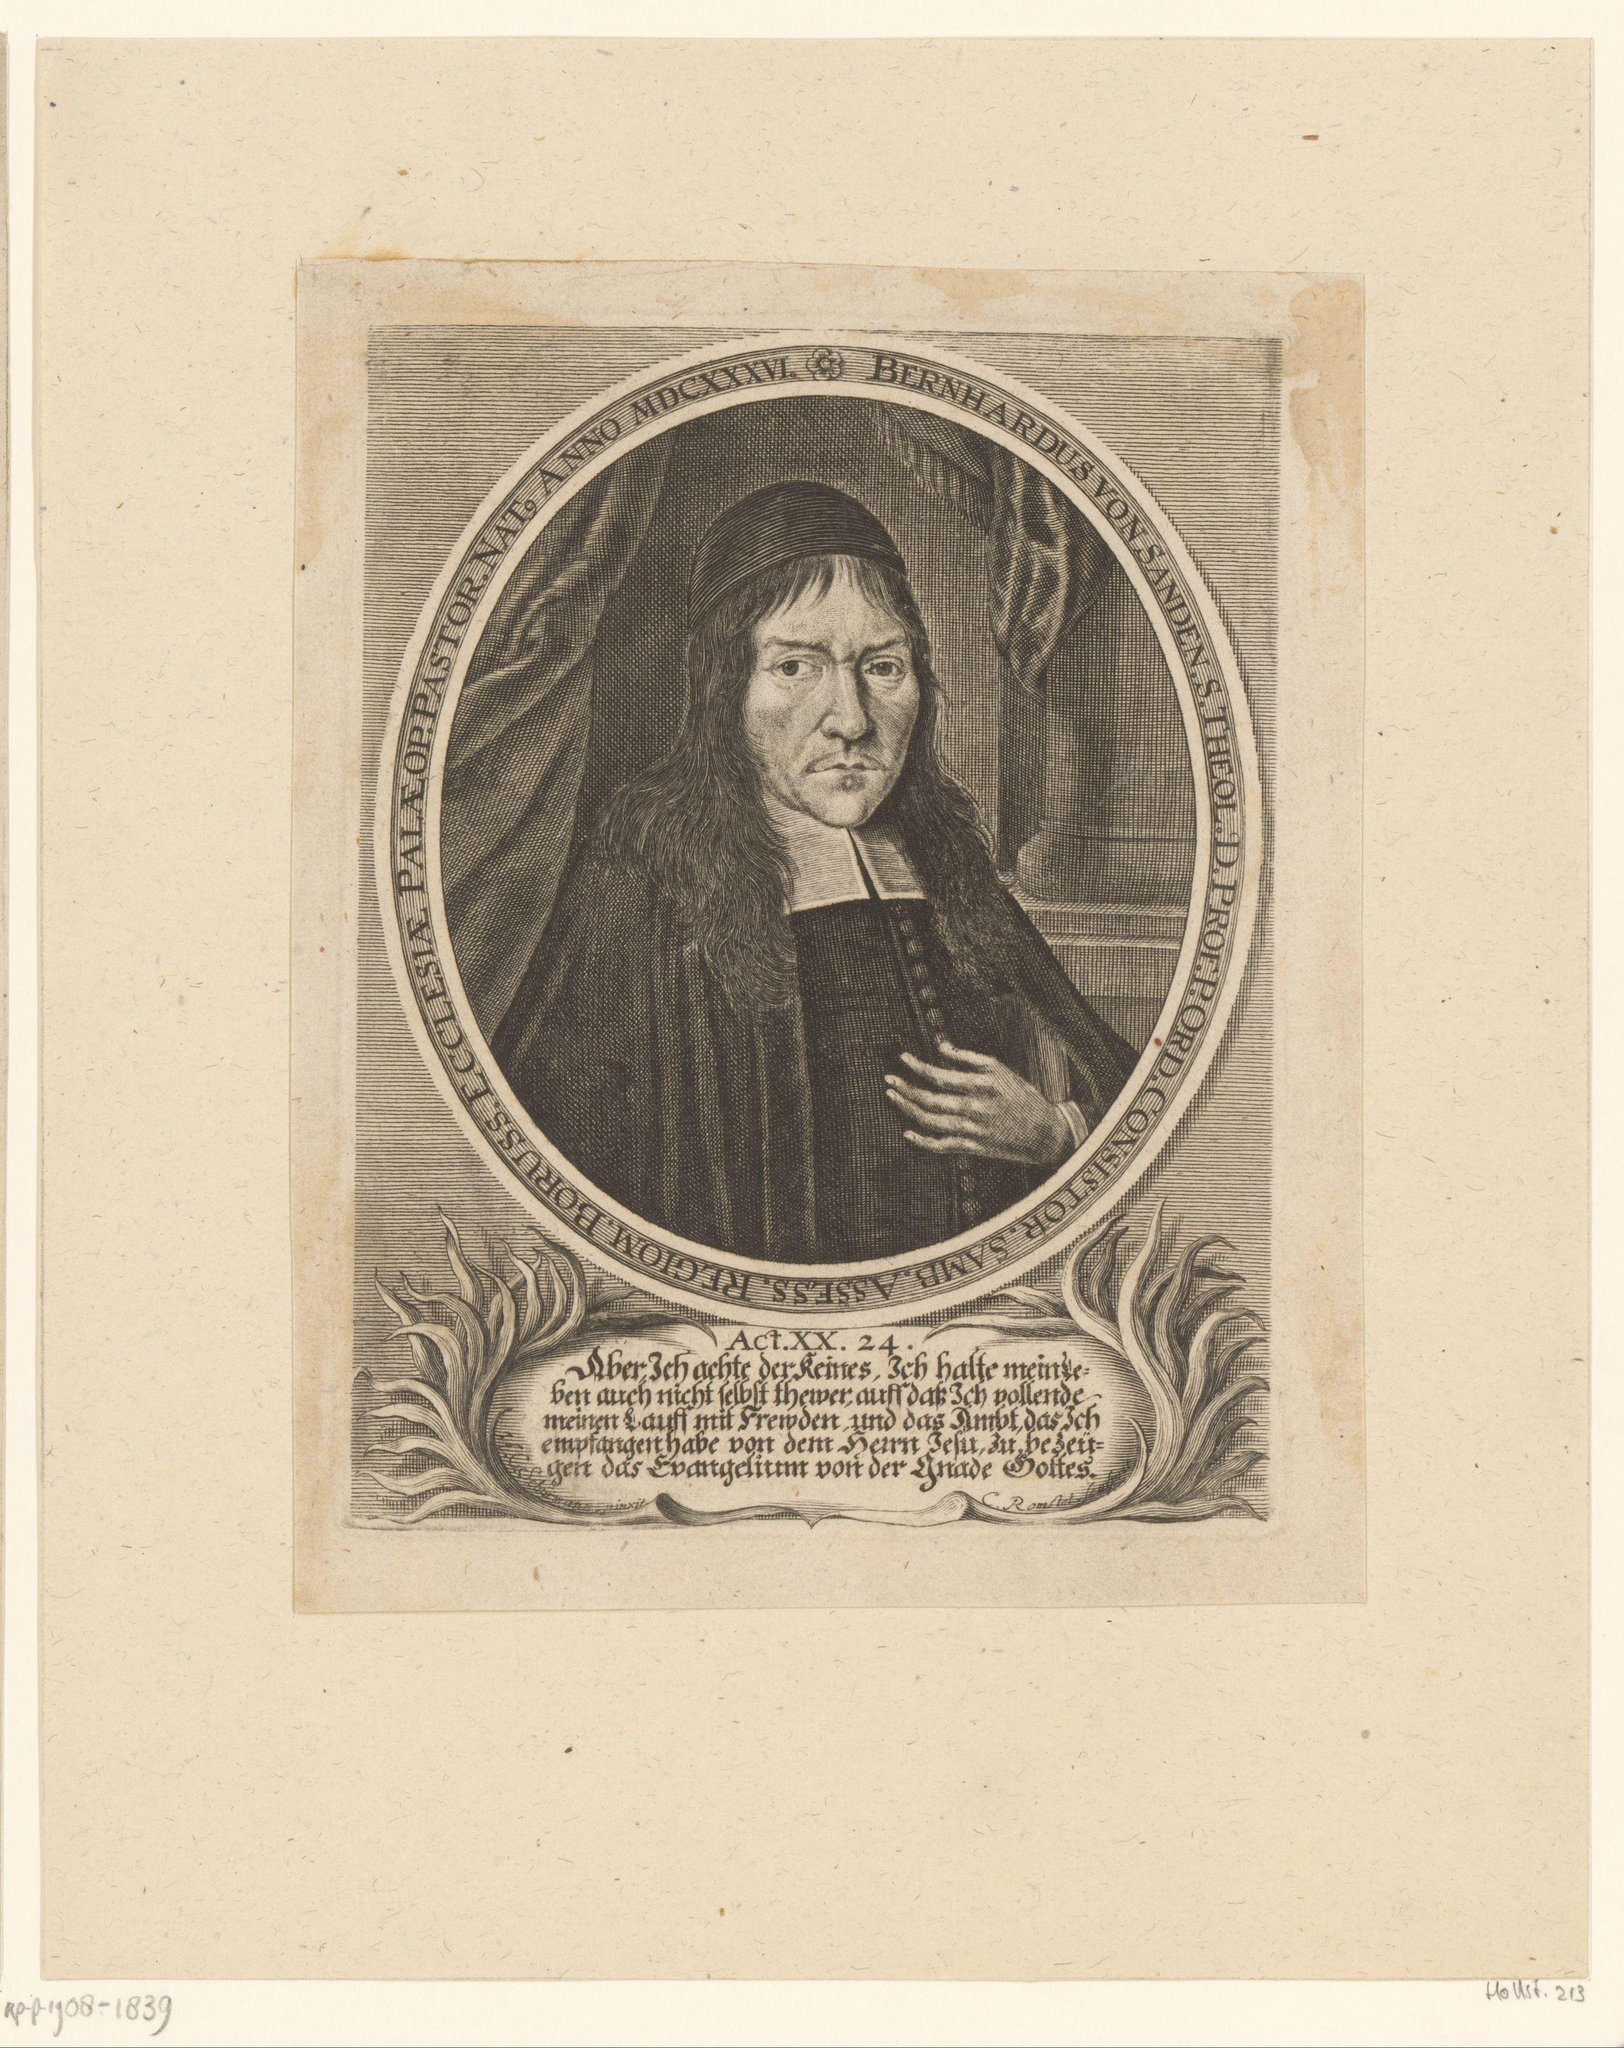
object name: print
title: Portret van Bernhard Sanden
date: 1665-1721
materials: paper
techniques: engraving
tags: bernhard von sanden, theologian, historical persons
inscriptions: collector's mark: Lugt 2228